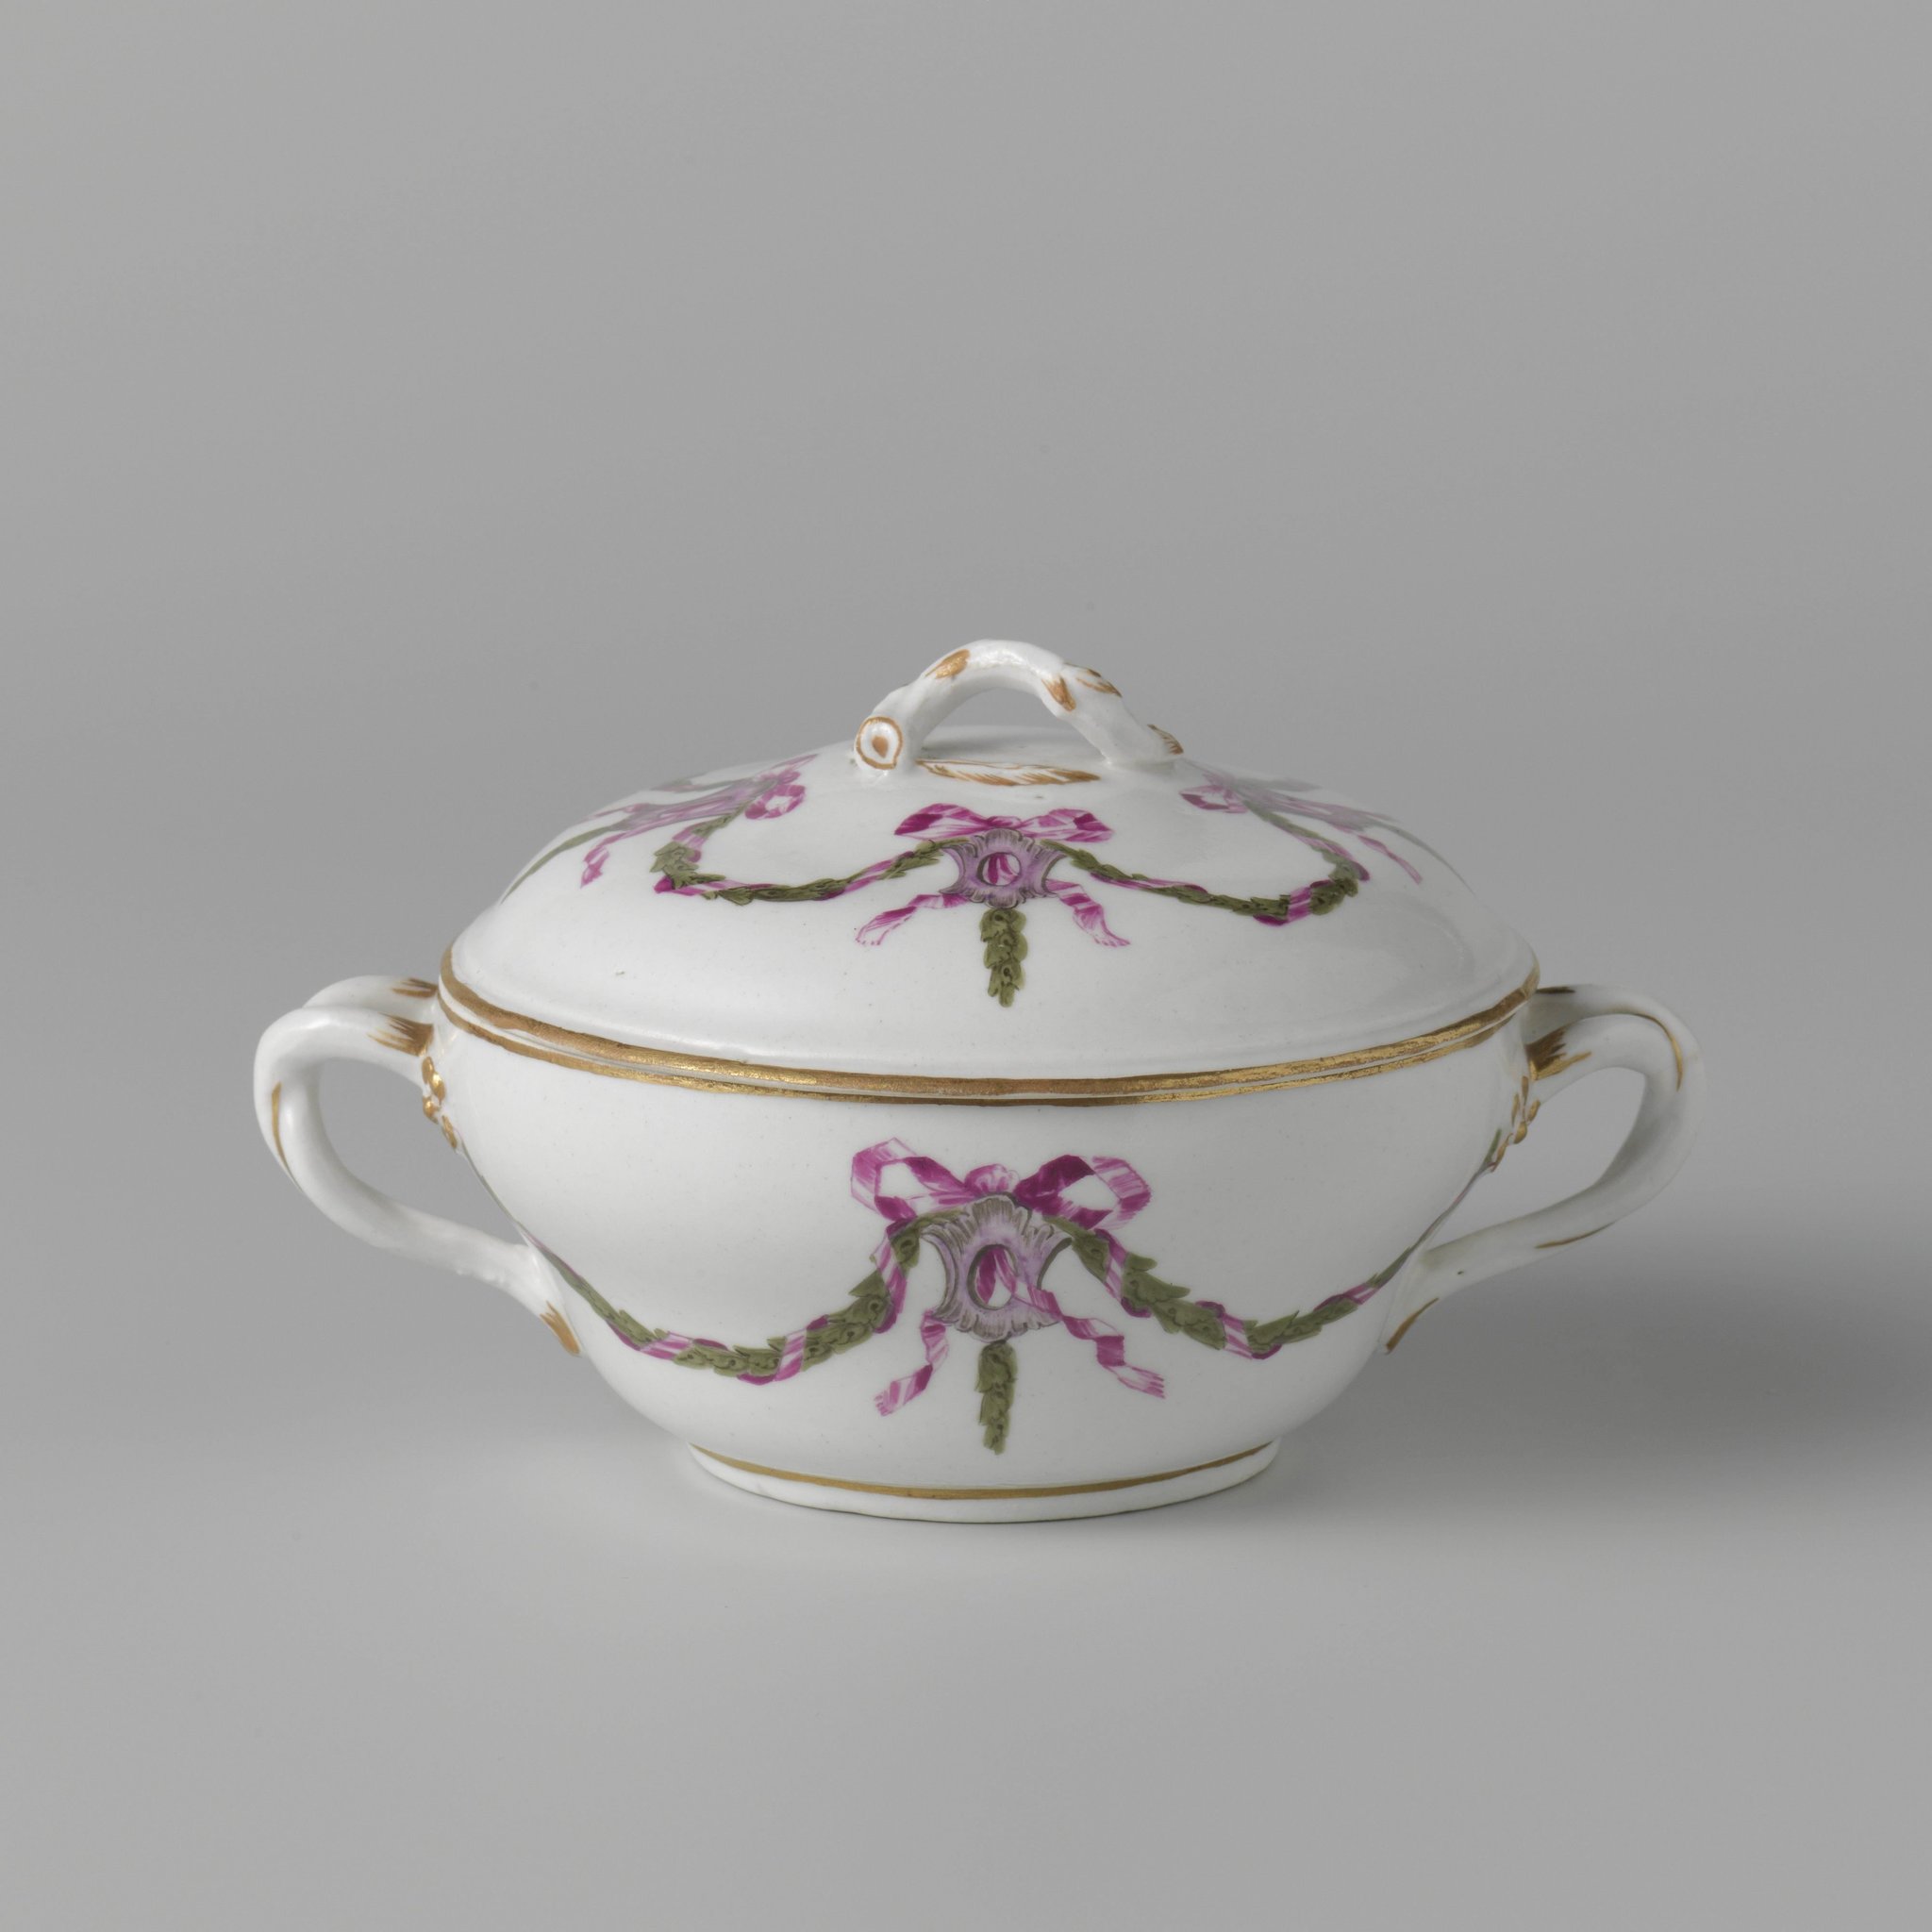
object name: tureen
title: Tureen and stand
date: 1778-1782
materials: porcelain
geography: loosdrecht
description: Manufactuur Oud-Loosdrecht Loosdrecht, c. 1778–1782 hard-paste porcelain